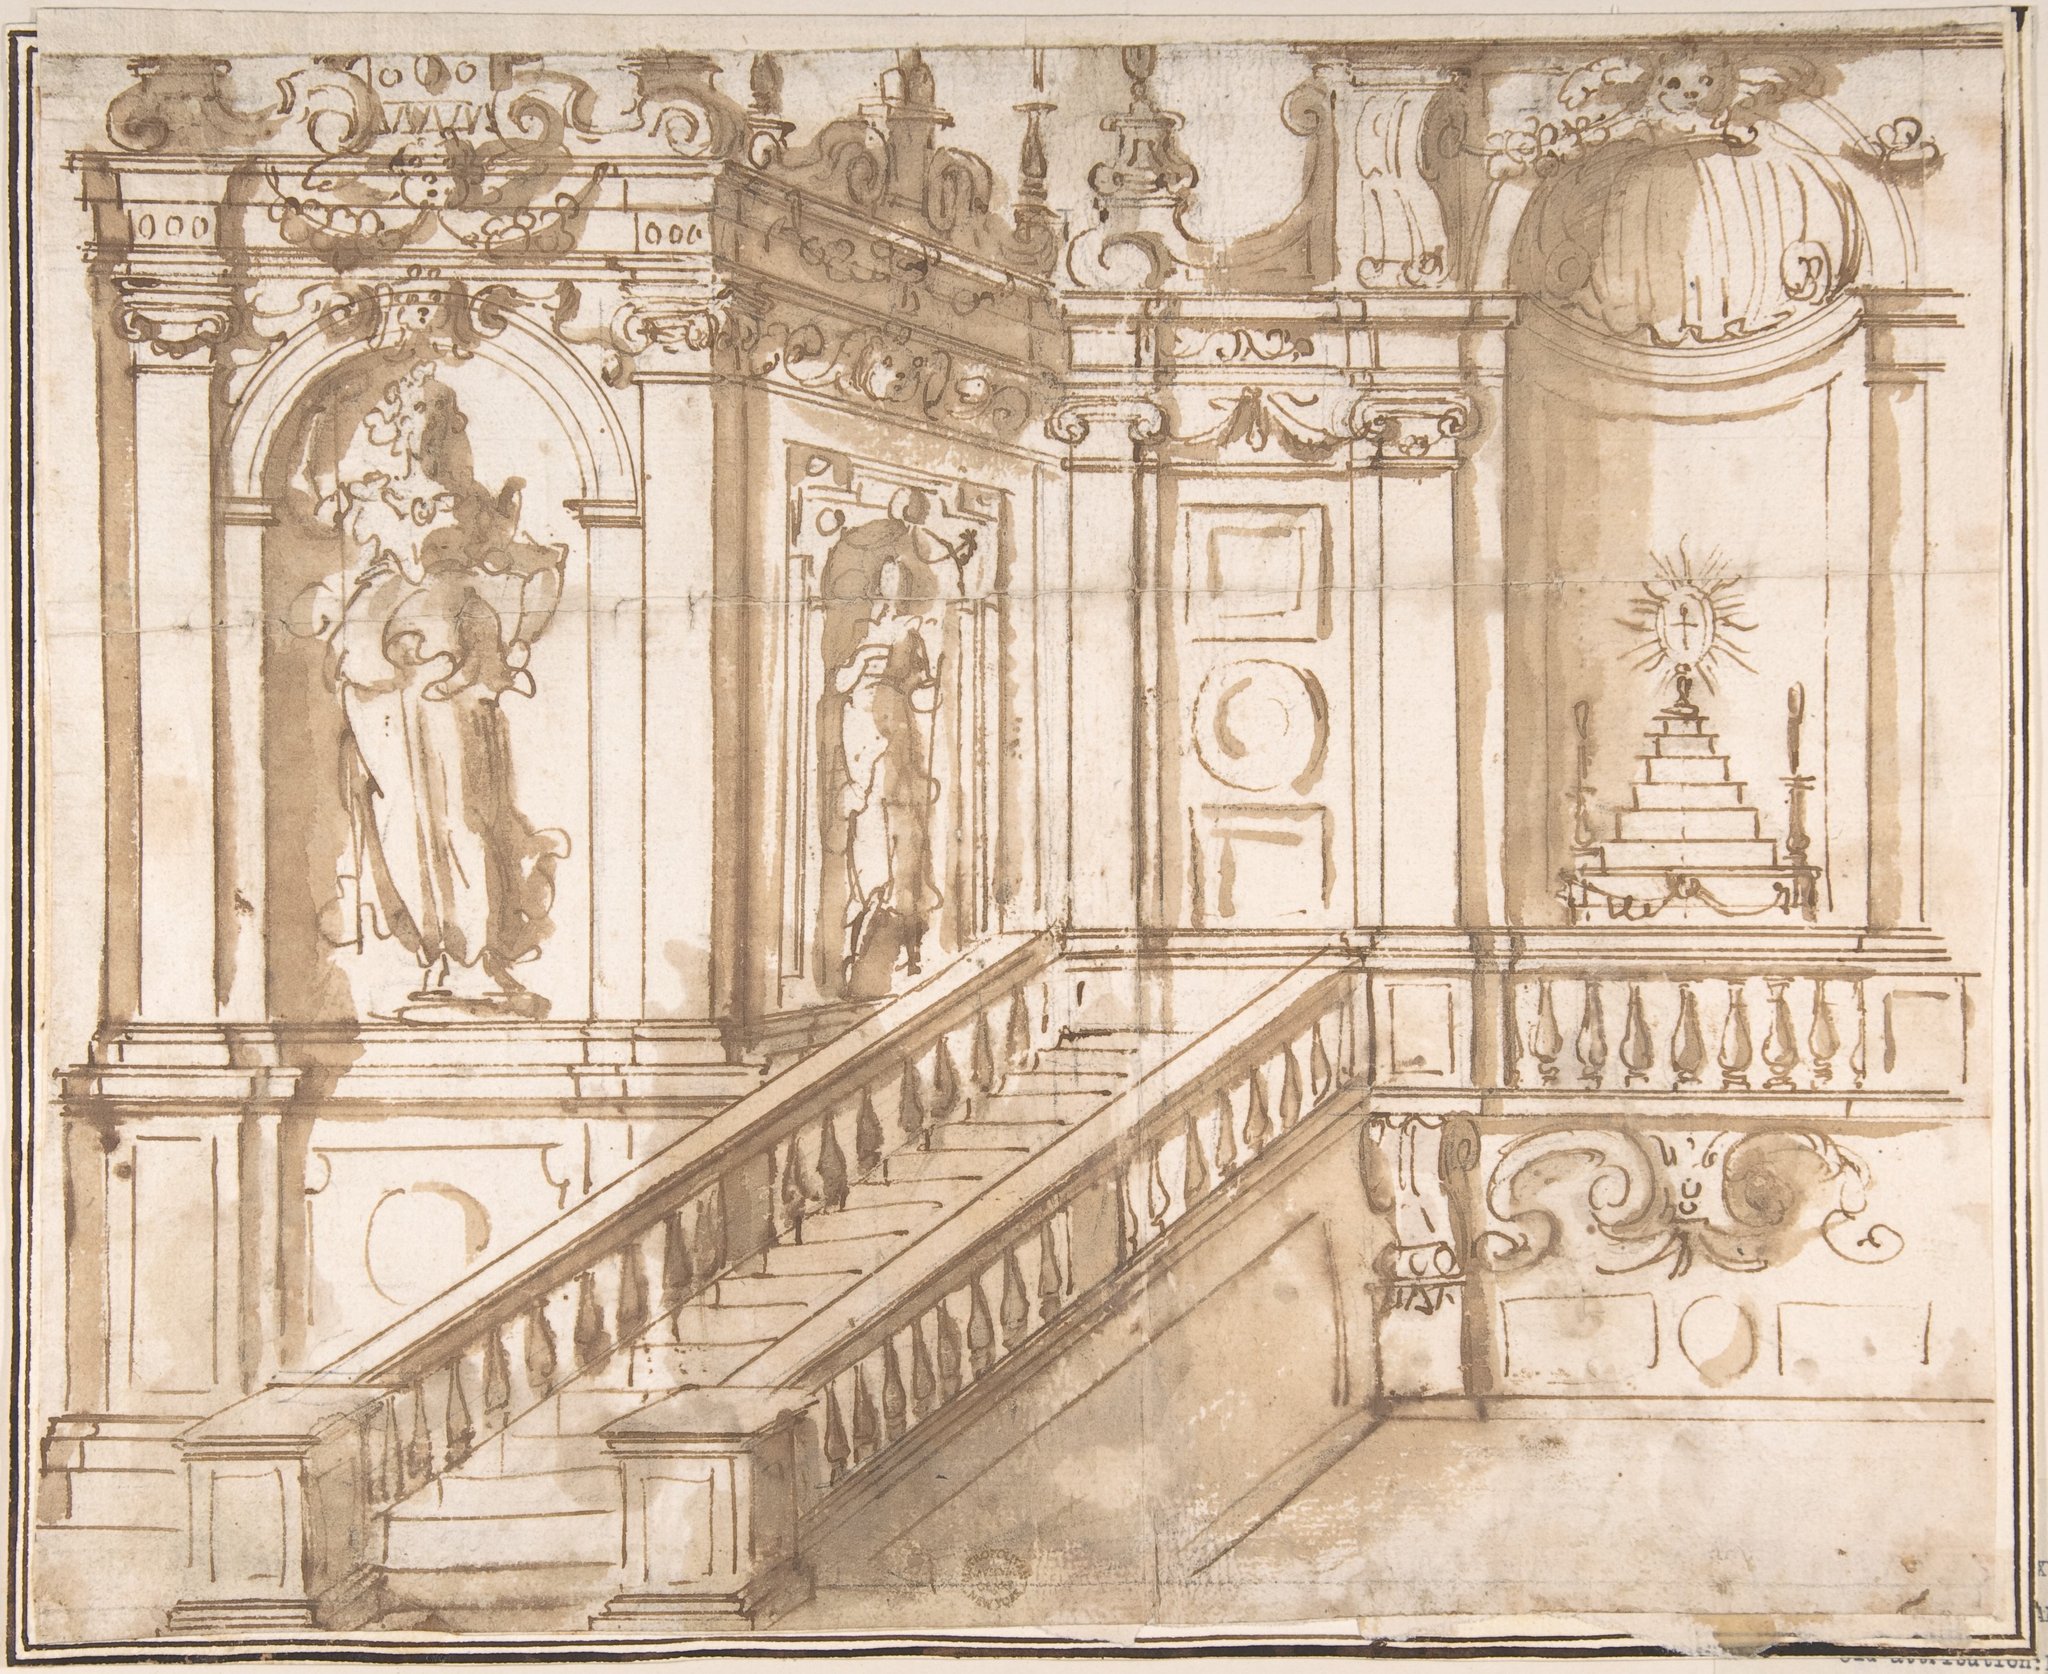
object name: drawing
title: Project of Altar Decoration (Stage Setting ?)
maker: anonymous, italian, 16th century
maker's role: artist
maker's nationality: italian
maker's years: 1550-1600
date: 1501-1600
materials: ink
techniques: pen, wash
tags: altars